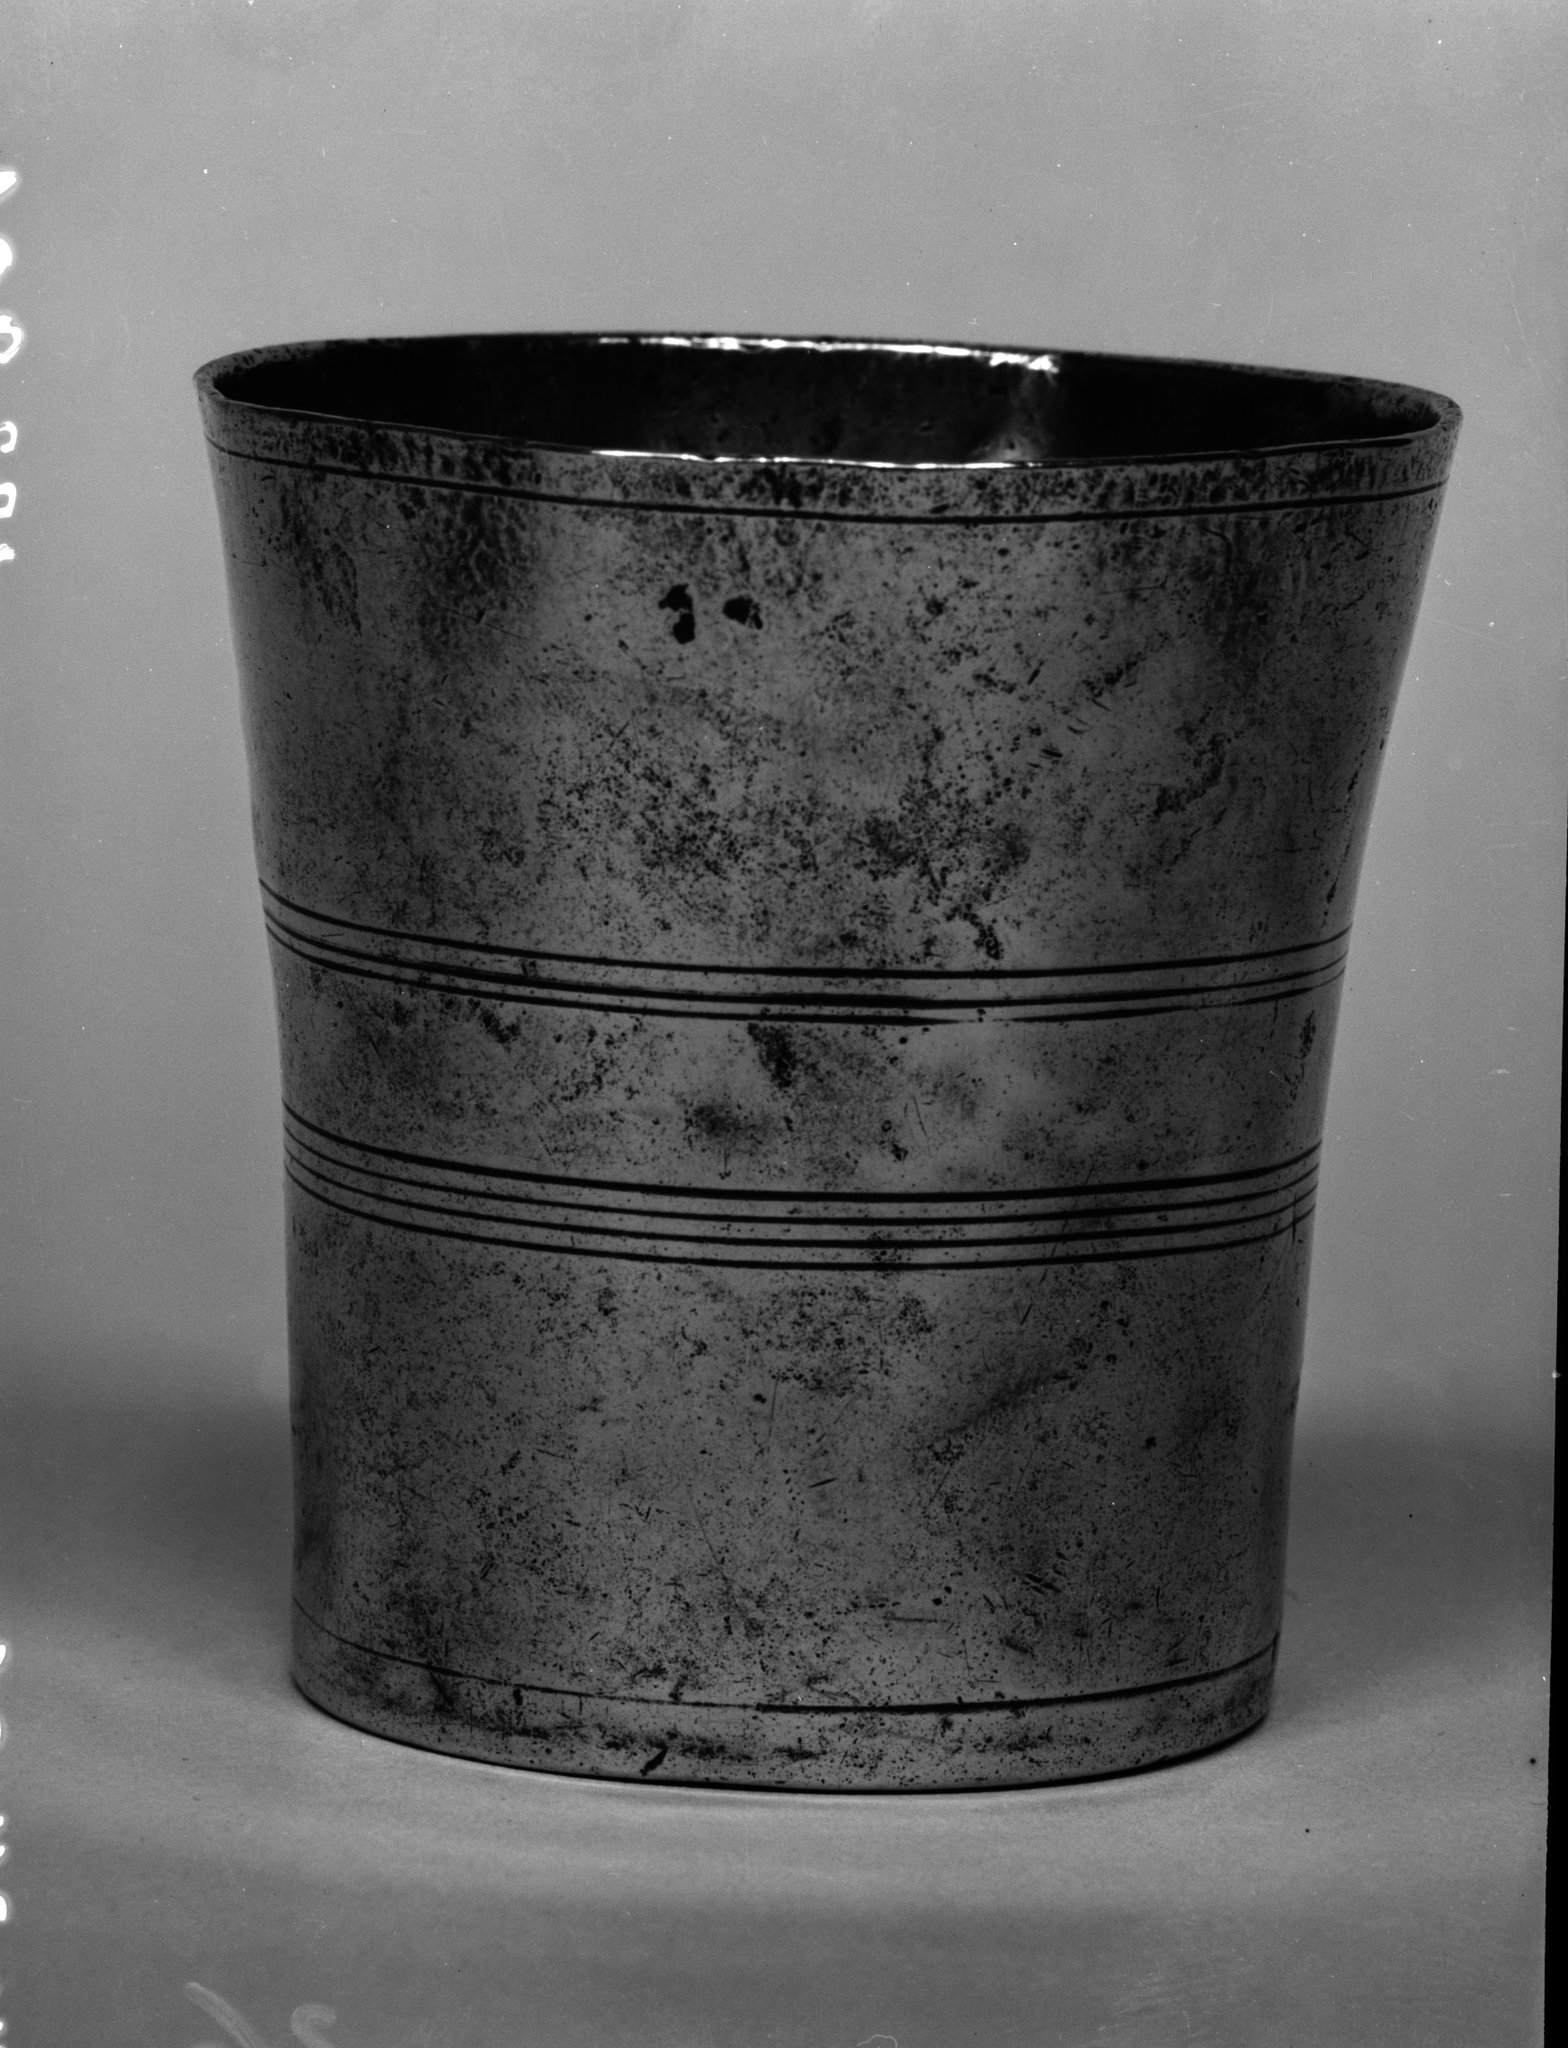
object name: beaker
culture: american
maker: ashbil griswold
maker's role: maker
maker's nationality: american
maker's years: 1784-1853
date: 1807-1835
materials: pewter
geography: united states